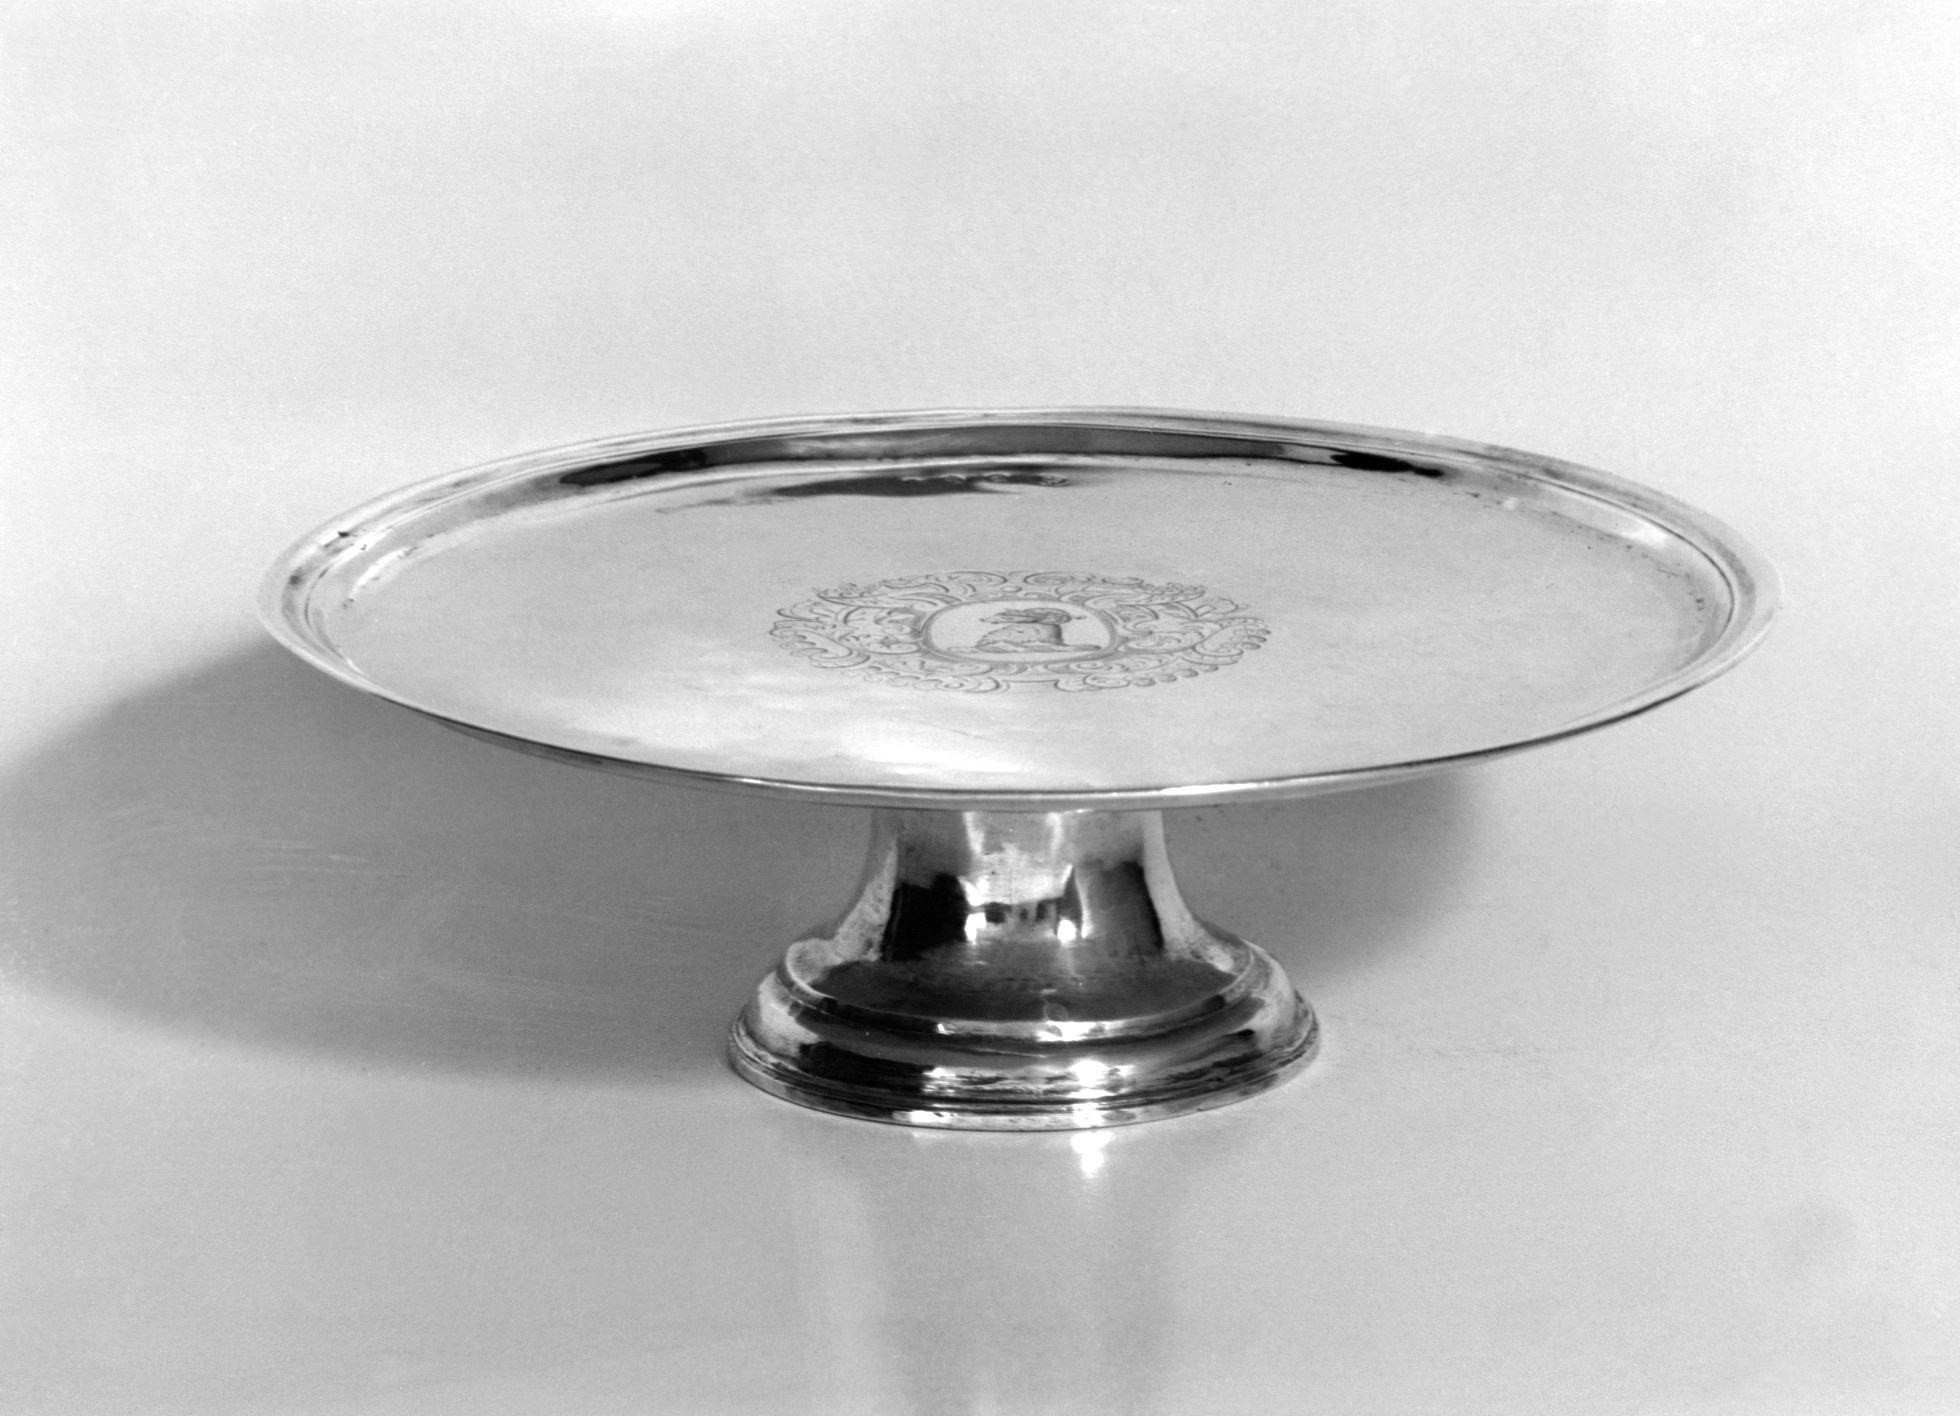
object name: salver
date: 1710-1711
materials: silver